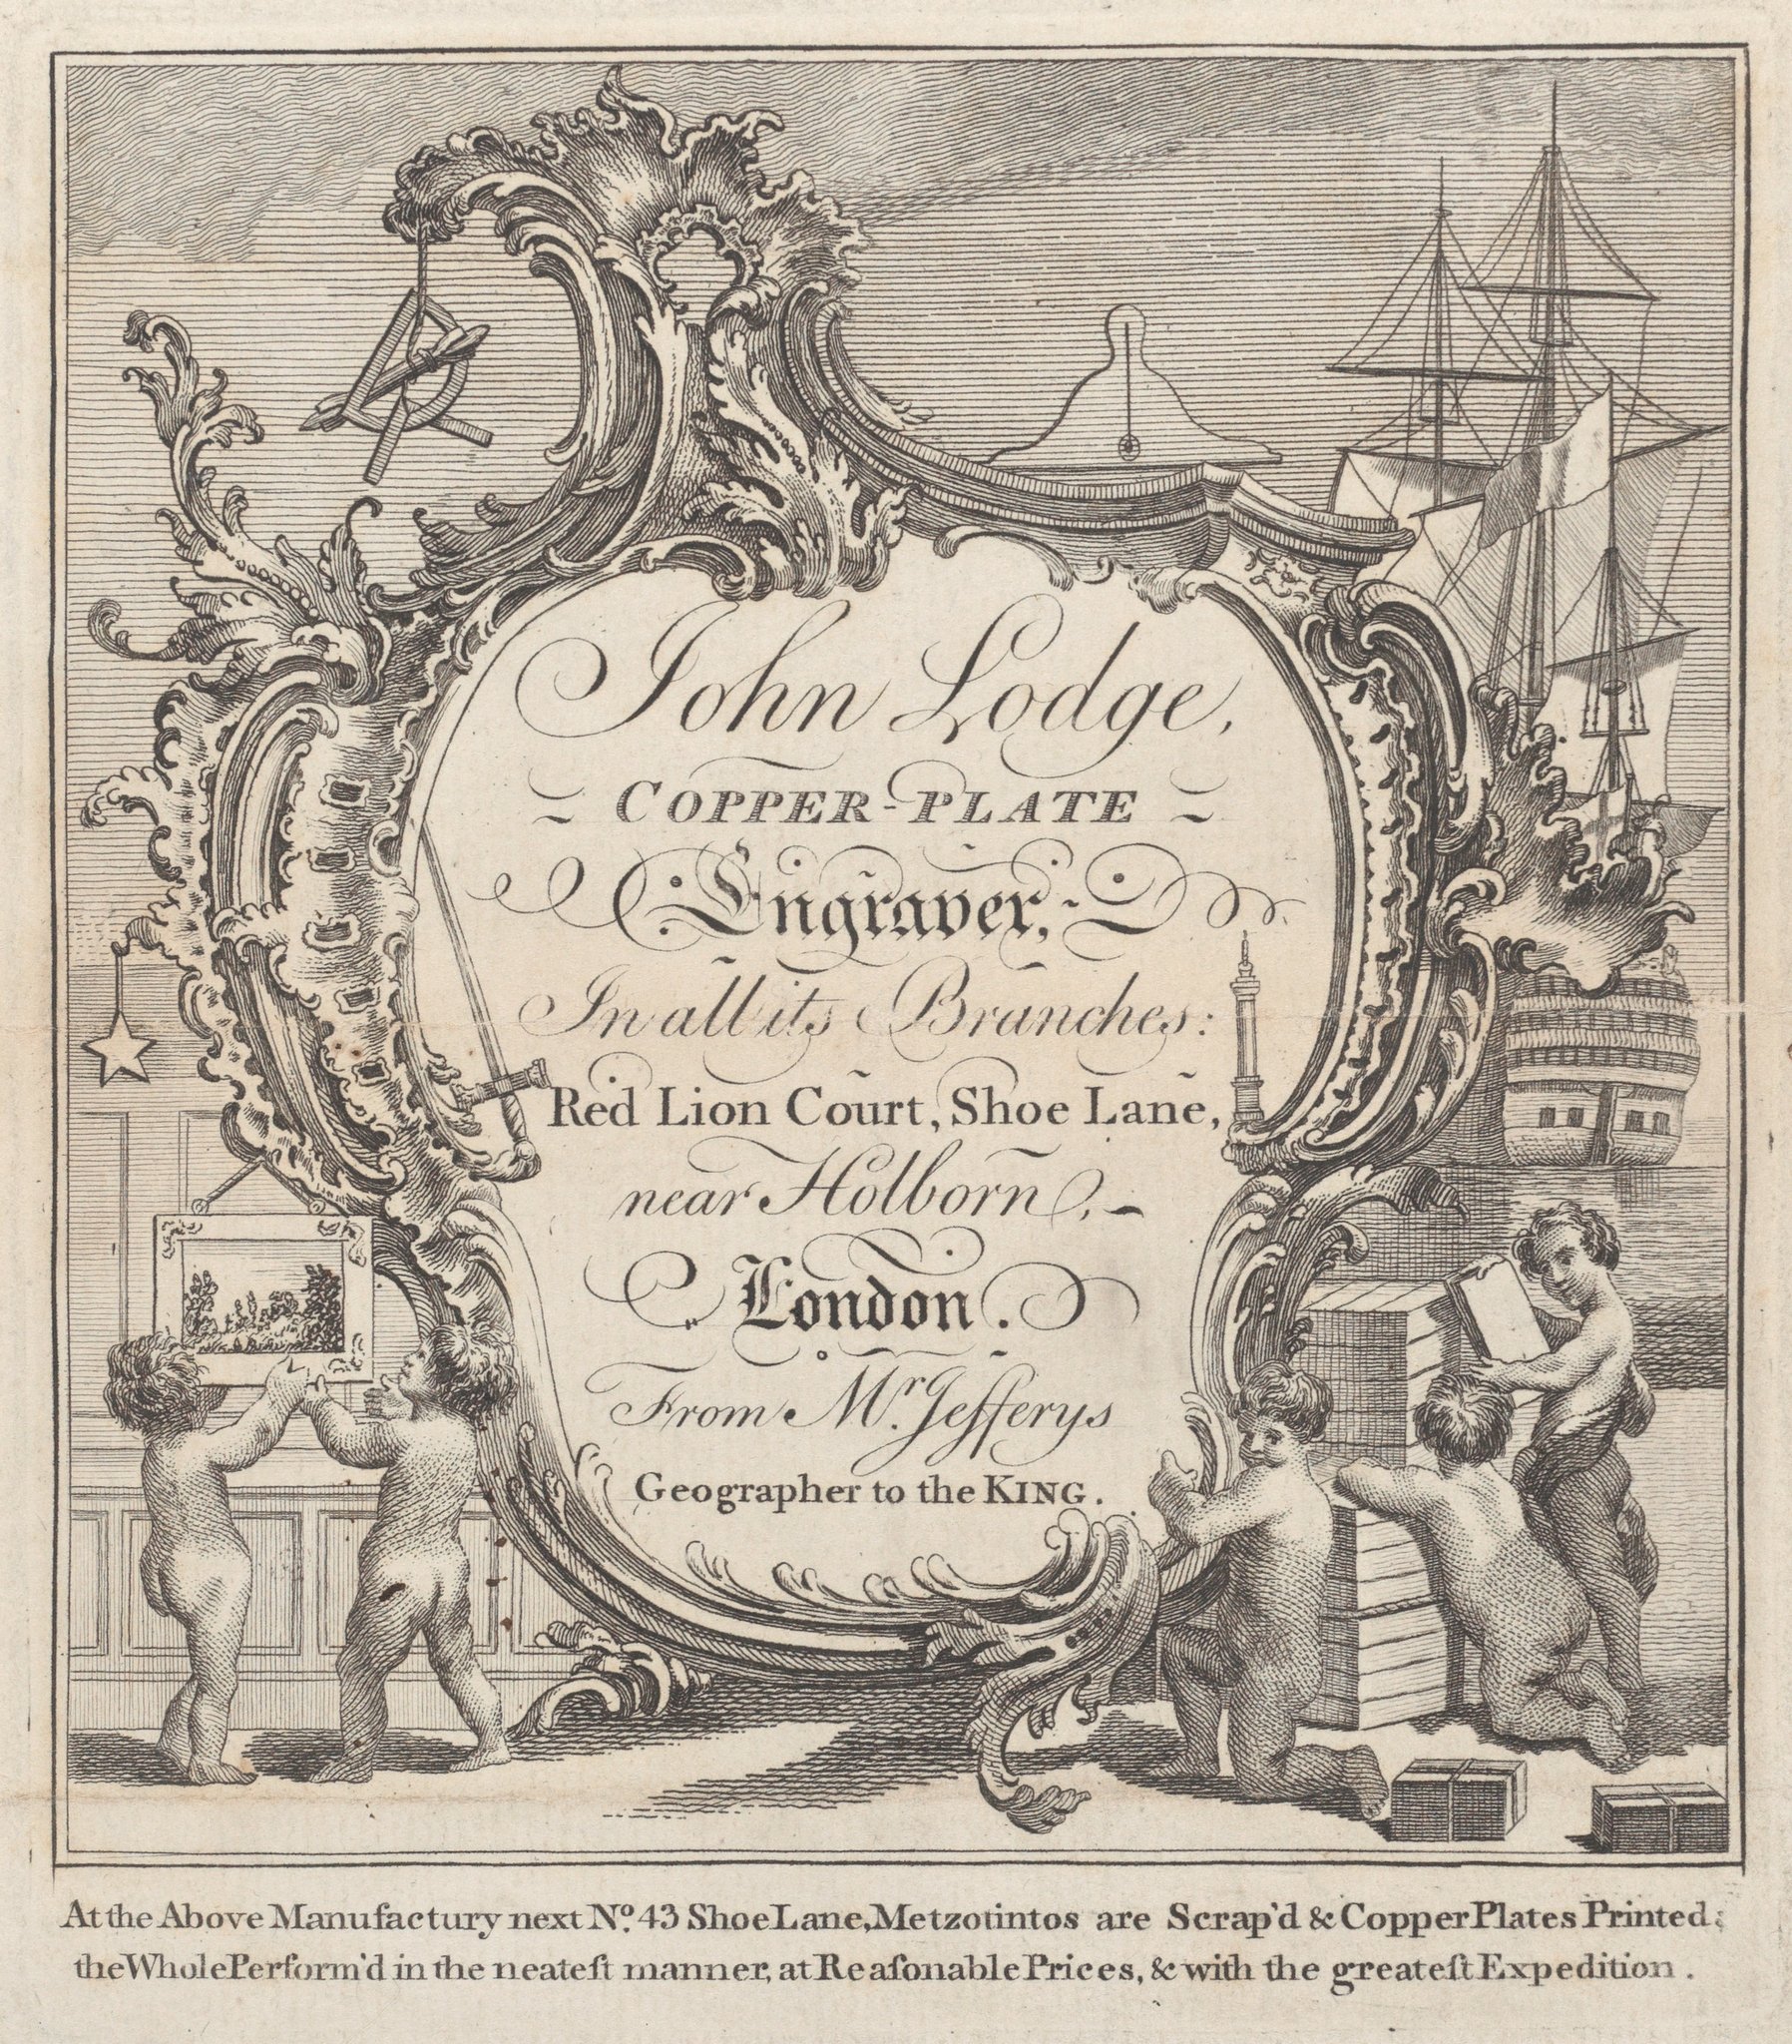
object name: print, trade card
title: Trade Card for John Lodge, Copper Plate Engraver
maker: anonymous, british, 18th century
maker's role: artist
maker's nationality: british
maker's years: 1700-1800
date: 1701-1800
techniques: engraving